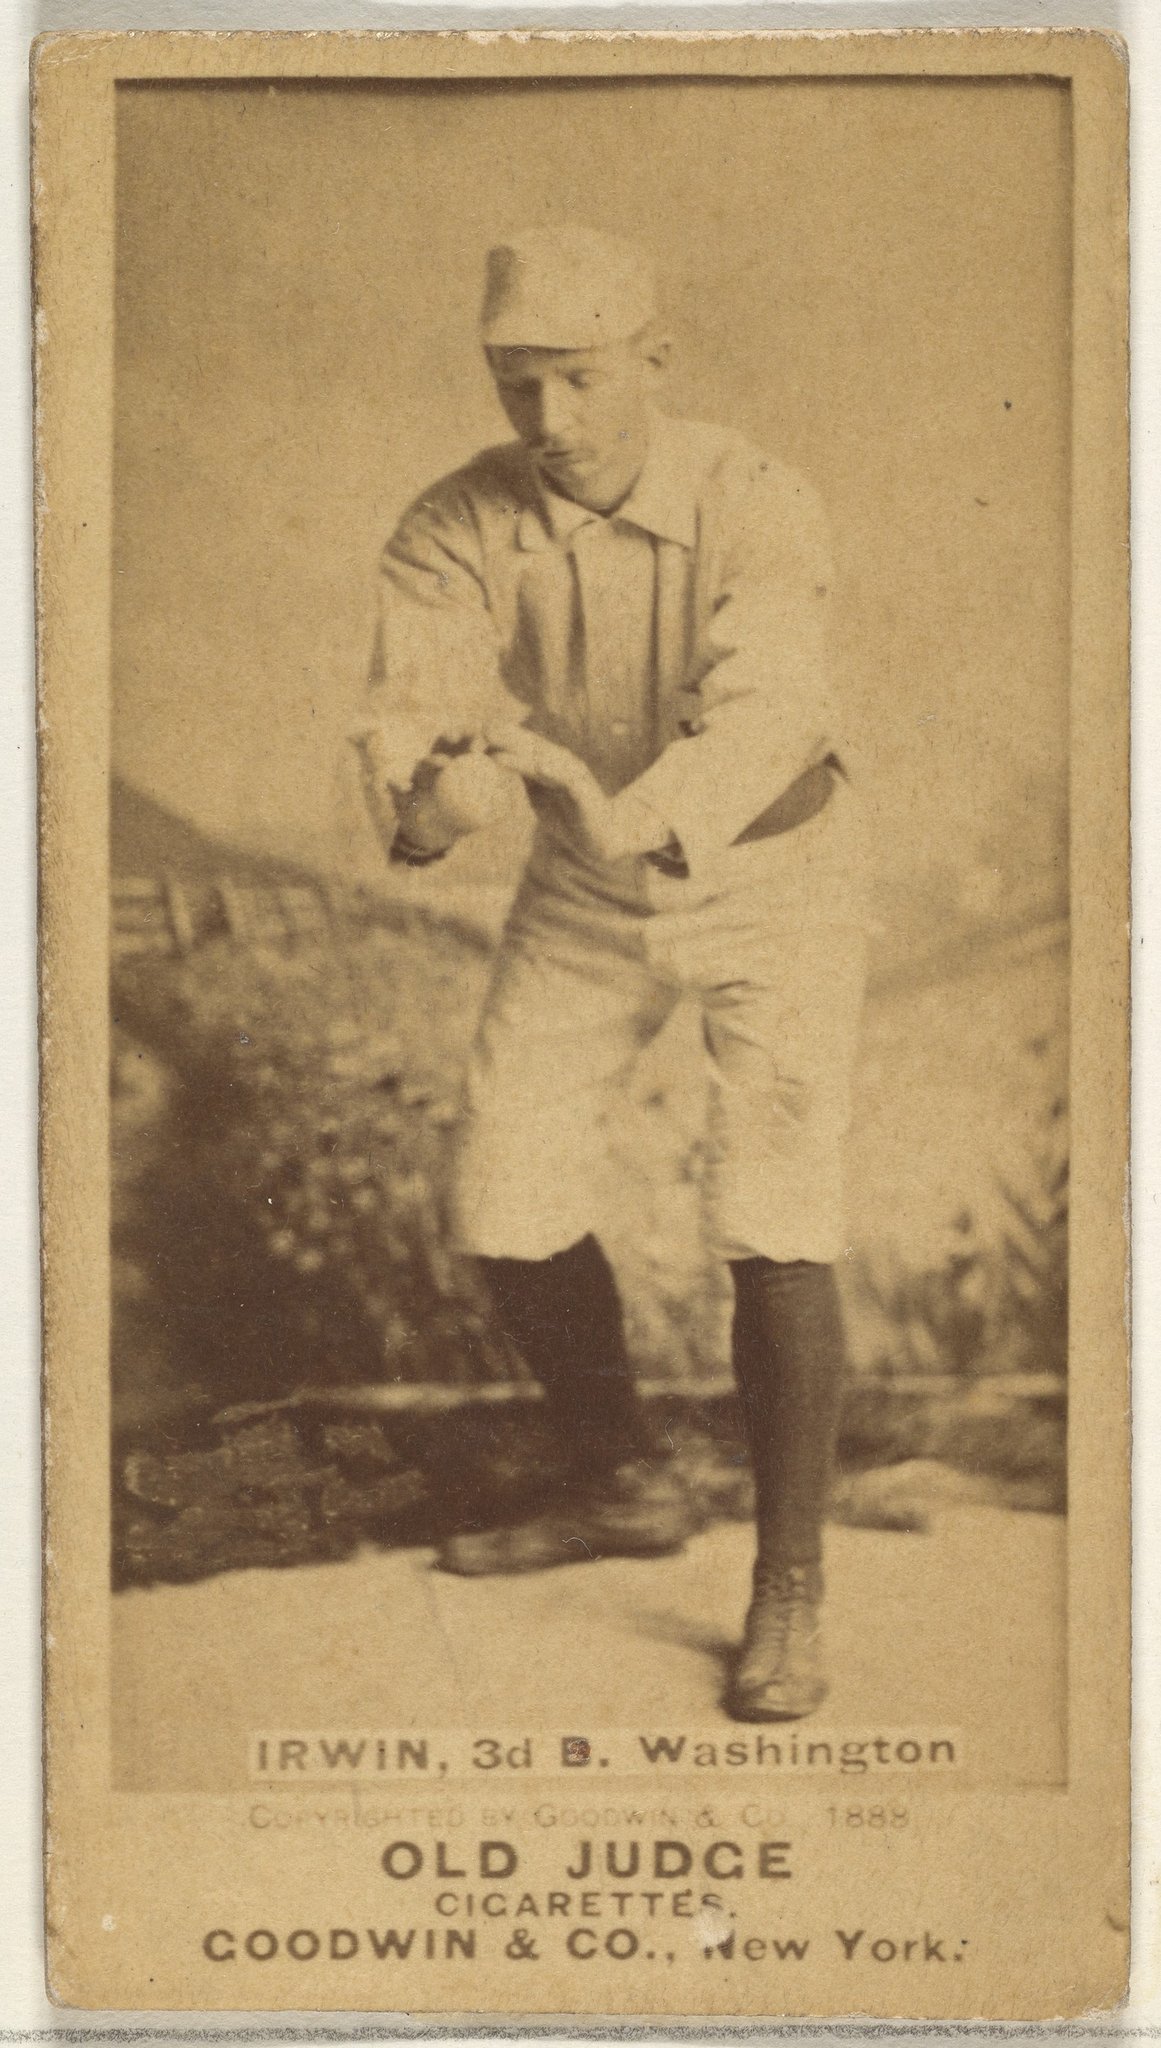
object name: baseball card, photograph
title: John Irwin, 3rd Base, Washington Nationals, from the Old Judge series (N172) for Old Judge Cigarettes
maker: goodwin & company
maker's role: publisher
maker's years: 1850-1950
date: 1888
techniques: albumen silver print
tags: men,portraits,baseball,athletes